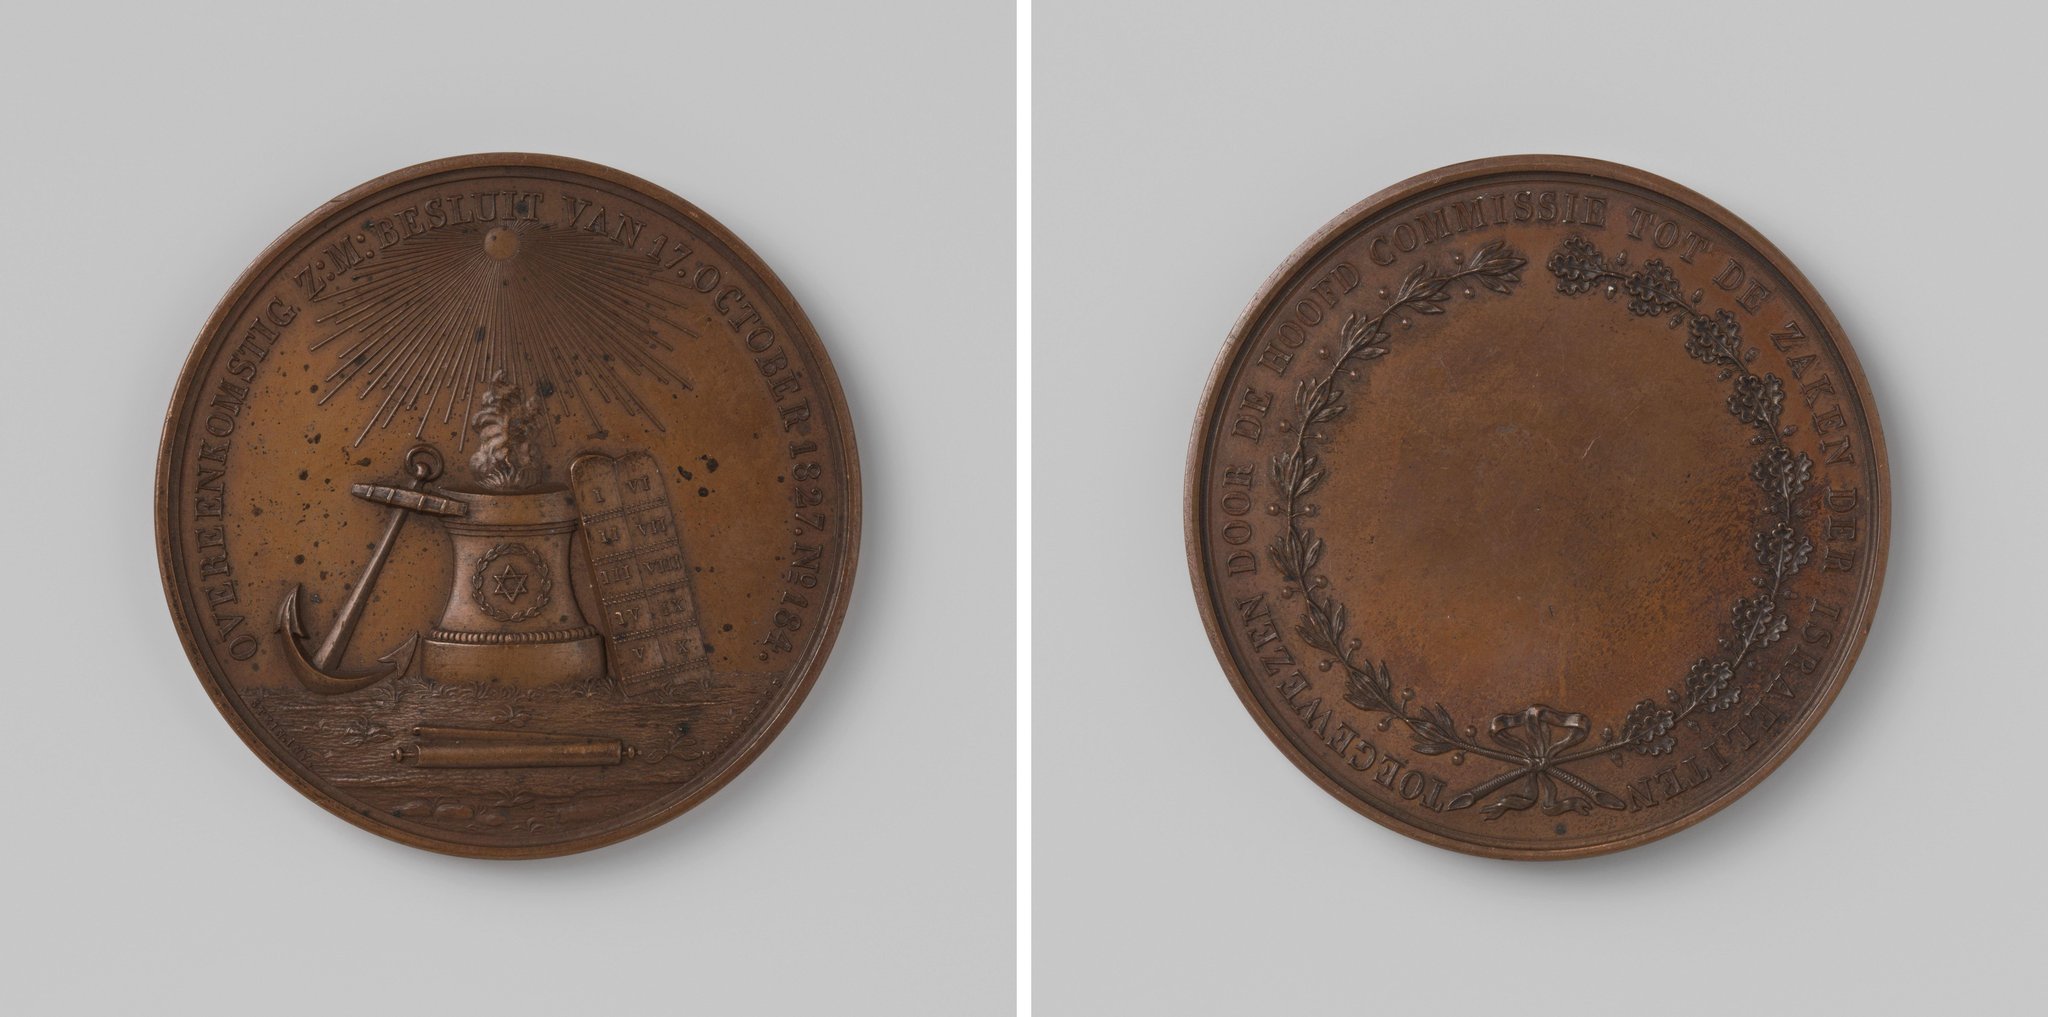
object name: medal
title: Hoofdcommissie tot de zaken der Israëlieten, prijspenning ingesteld overeenkomstig Koninklijk Besluit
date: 1827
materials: bronze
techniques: striking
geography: netherlands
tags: the hague, berlin, william i of the netherlands